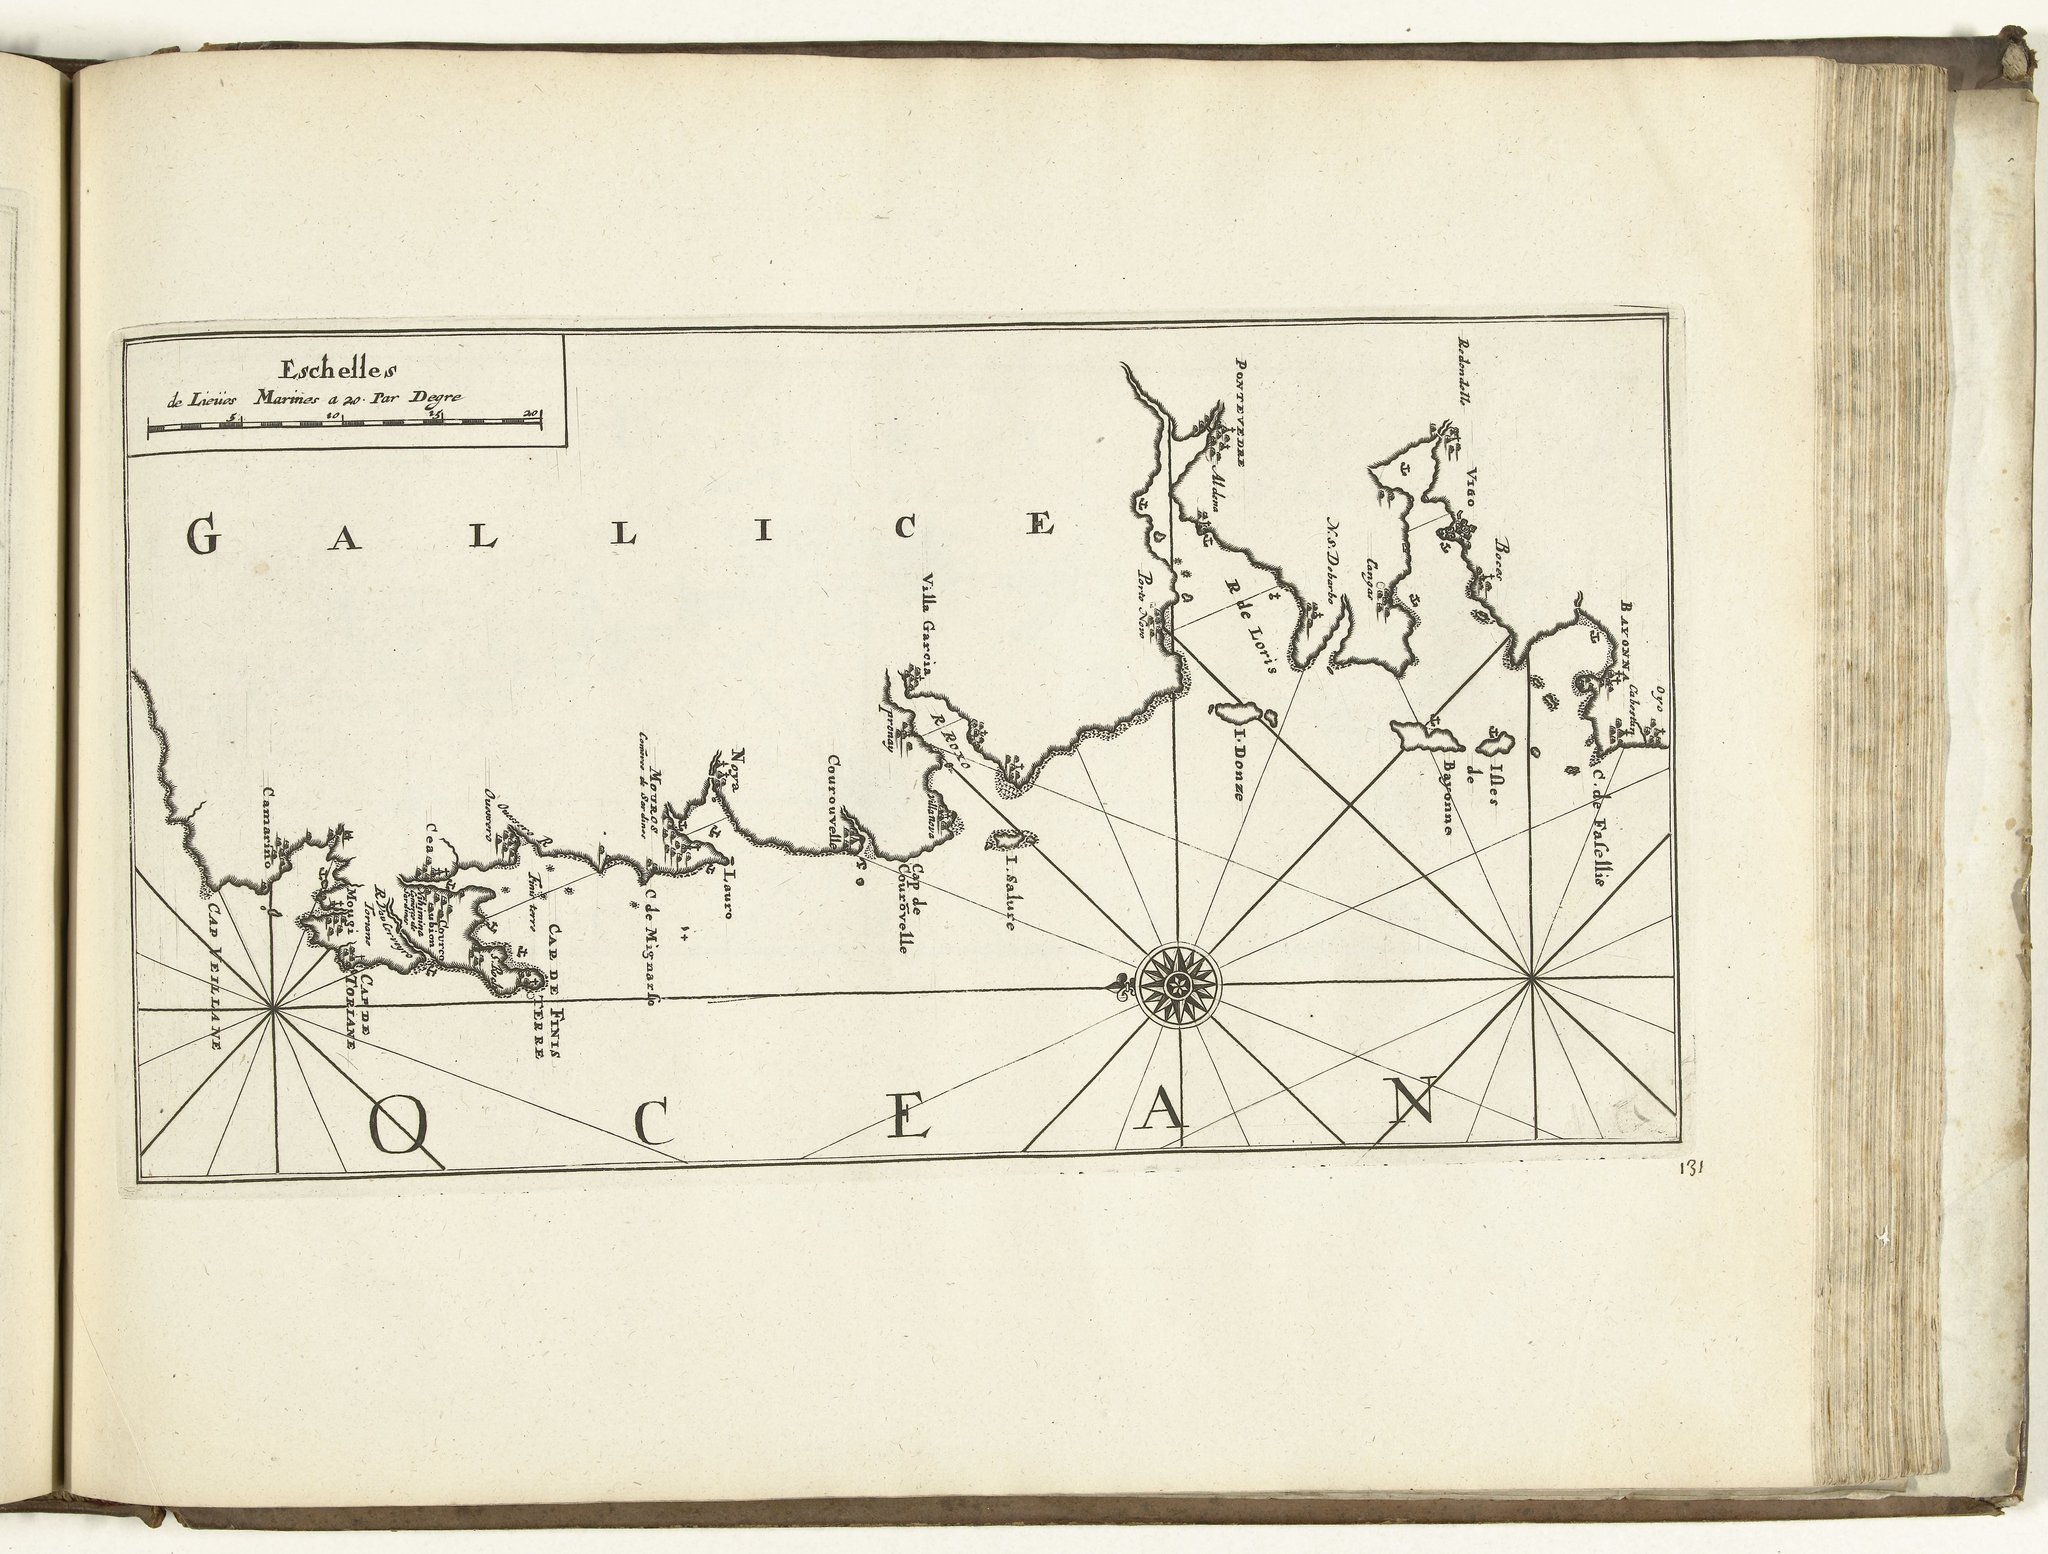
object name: print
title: Kaart van de westkust van Galicië, 1726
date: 1726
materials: paper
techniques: engraving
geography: northern netherlands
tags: maps of separate countries or regions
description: Kaart van de westkust van Galicië. Plaat nr. 131 in deel VI van het prentwerk: Les Forces de l'Europe, Asie, Afrique et Amerique ... Comme aussi les Cartes des Côtes de France et d'Espagne uit 1726, dit eerste deel met 238 met de hand genummerde platen van vermaarde sterke steden en vestingen in het kader van de Spaanse Successieoorlog 1701-1713. Voor het merendeel zijn deze platen gekopieerd naar de anonieme Franse platen van vermaarde sterke steden en vestingen: in Les forces de l'Europe en in: Le theatre de la guerre, dans les Pays-Bas, beide oorspronkelijk uitgegeven door Nicolas de Fer te Parijs (1693-1697) in het kader van de Negenjarige Oorlog. Opschriften in het Frans.